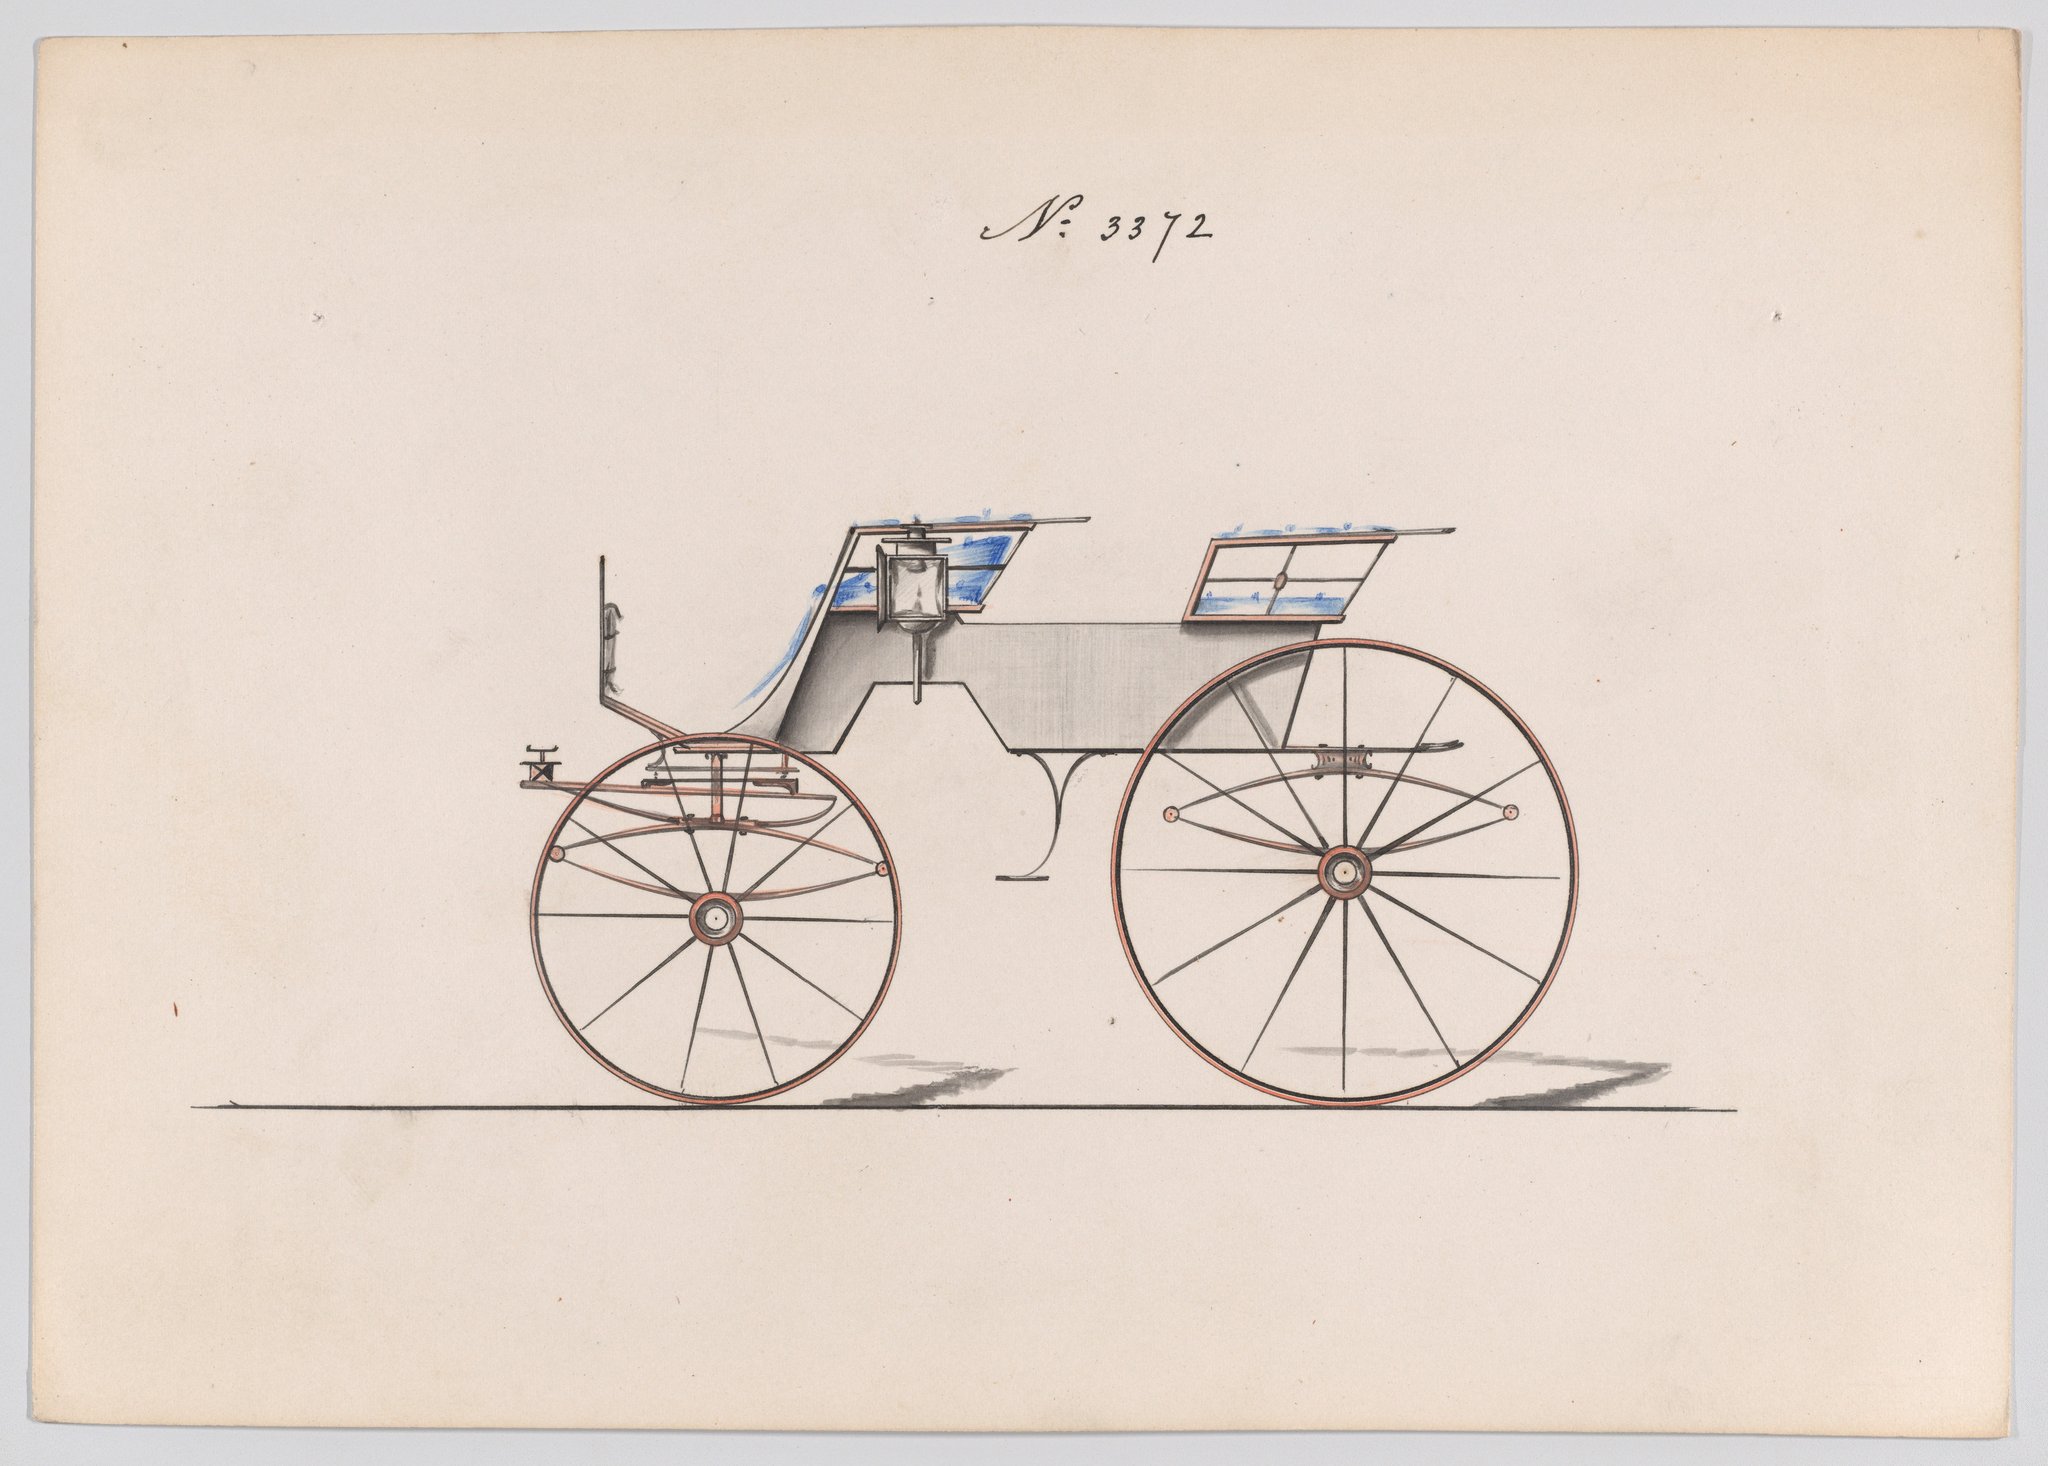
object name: drawing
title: Design for T-Cart, no. 3372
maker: brewster & co.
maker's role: manufacturer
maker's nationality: american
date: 1877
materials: gouache, ink, watercolor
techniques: pen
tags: carriages